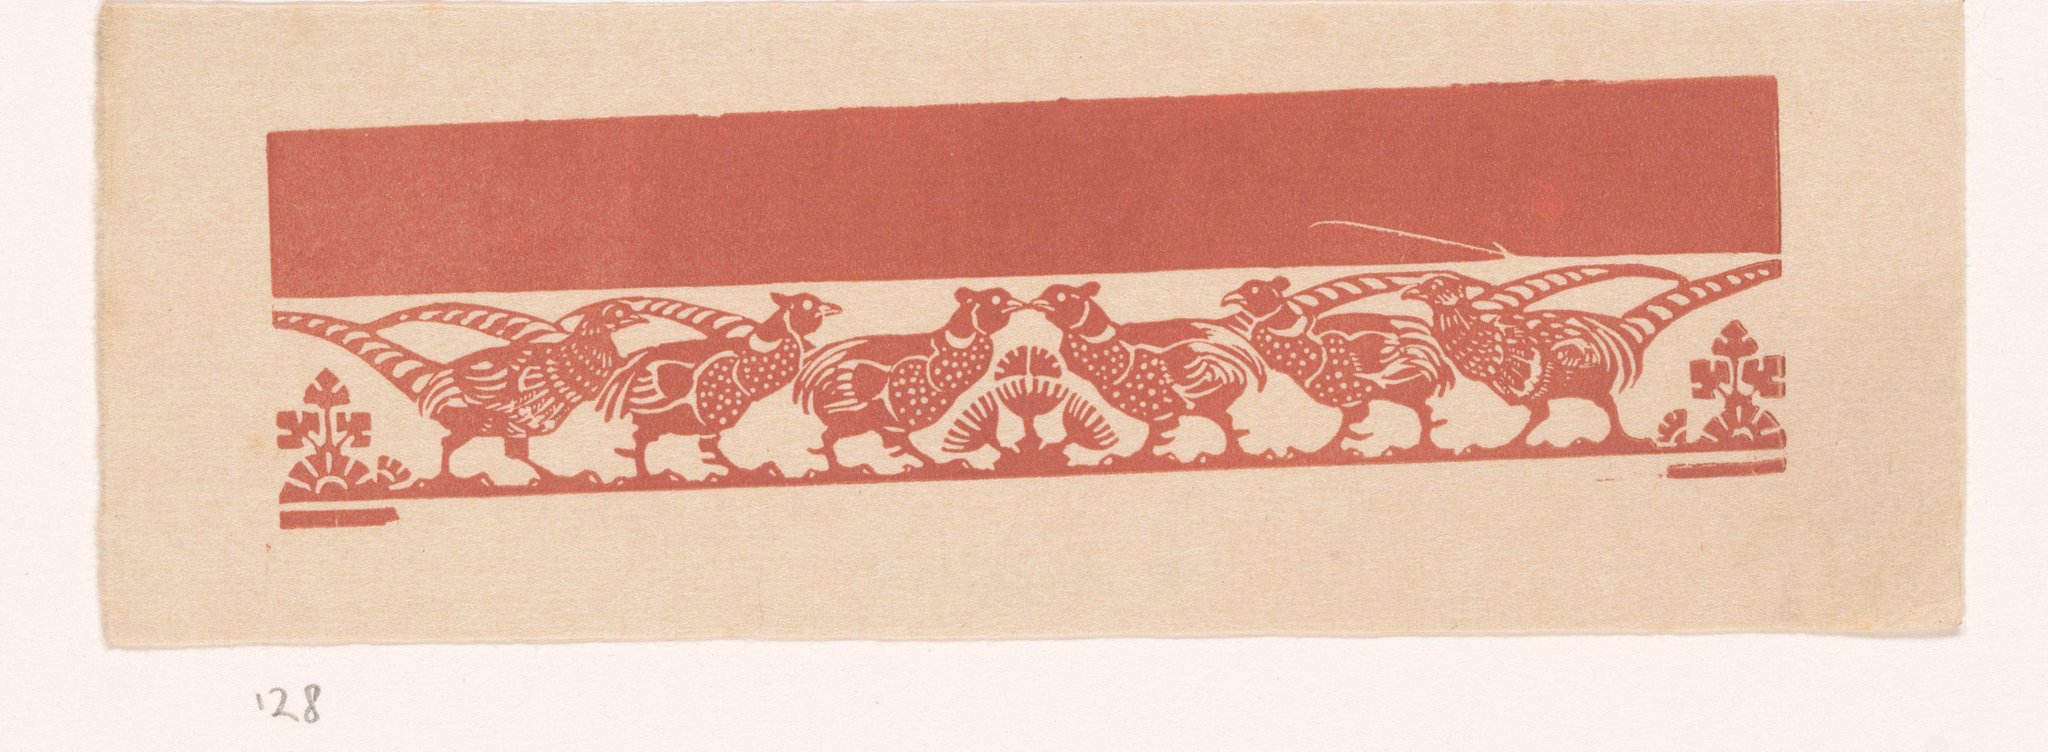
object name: print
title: Ornamentele rand met eksters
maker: bernard willem wierink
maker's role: draughtsman, print maker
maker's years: 1856-1939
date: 1910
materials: paper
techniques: relief print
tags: fable of reynard the fox, song-birds: magpie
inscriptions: collector's mark: Lugt 2228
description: Ontwerp voor: Streuvels, Stijn (Frank Lateur). Reinaert de Vos naar verschillende uitgaven van het middeleeuwsche epos. Amsterdam: L.J. Veen, 1910. Deze prent is vermoedelijk een plaatsnede, ook al wordt in de literatuur veelal gesproken over een houtsnede. Voor zover Wierink zijn prenten in hoogdruk zelf nader heeft omschreven, heeft hij altijd de term 'plaatsnede' gebruikt.